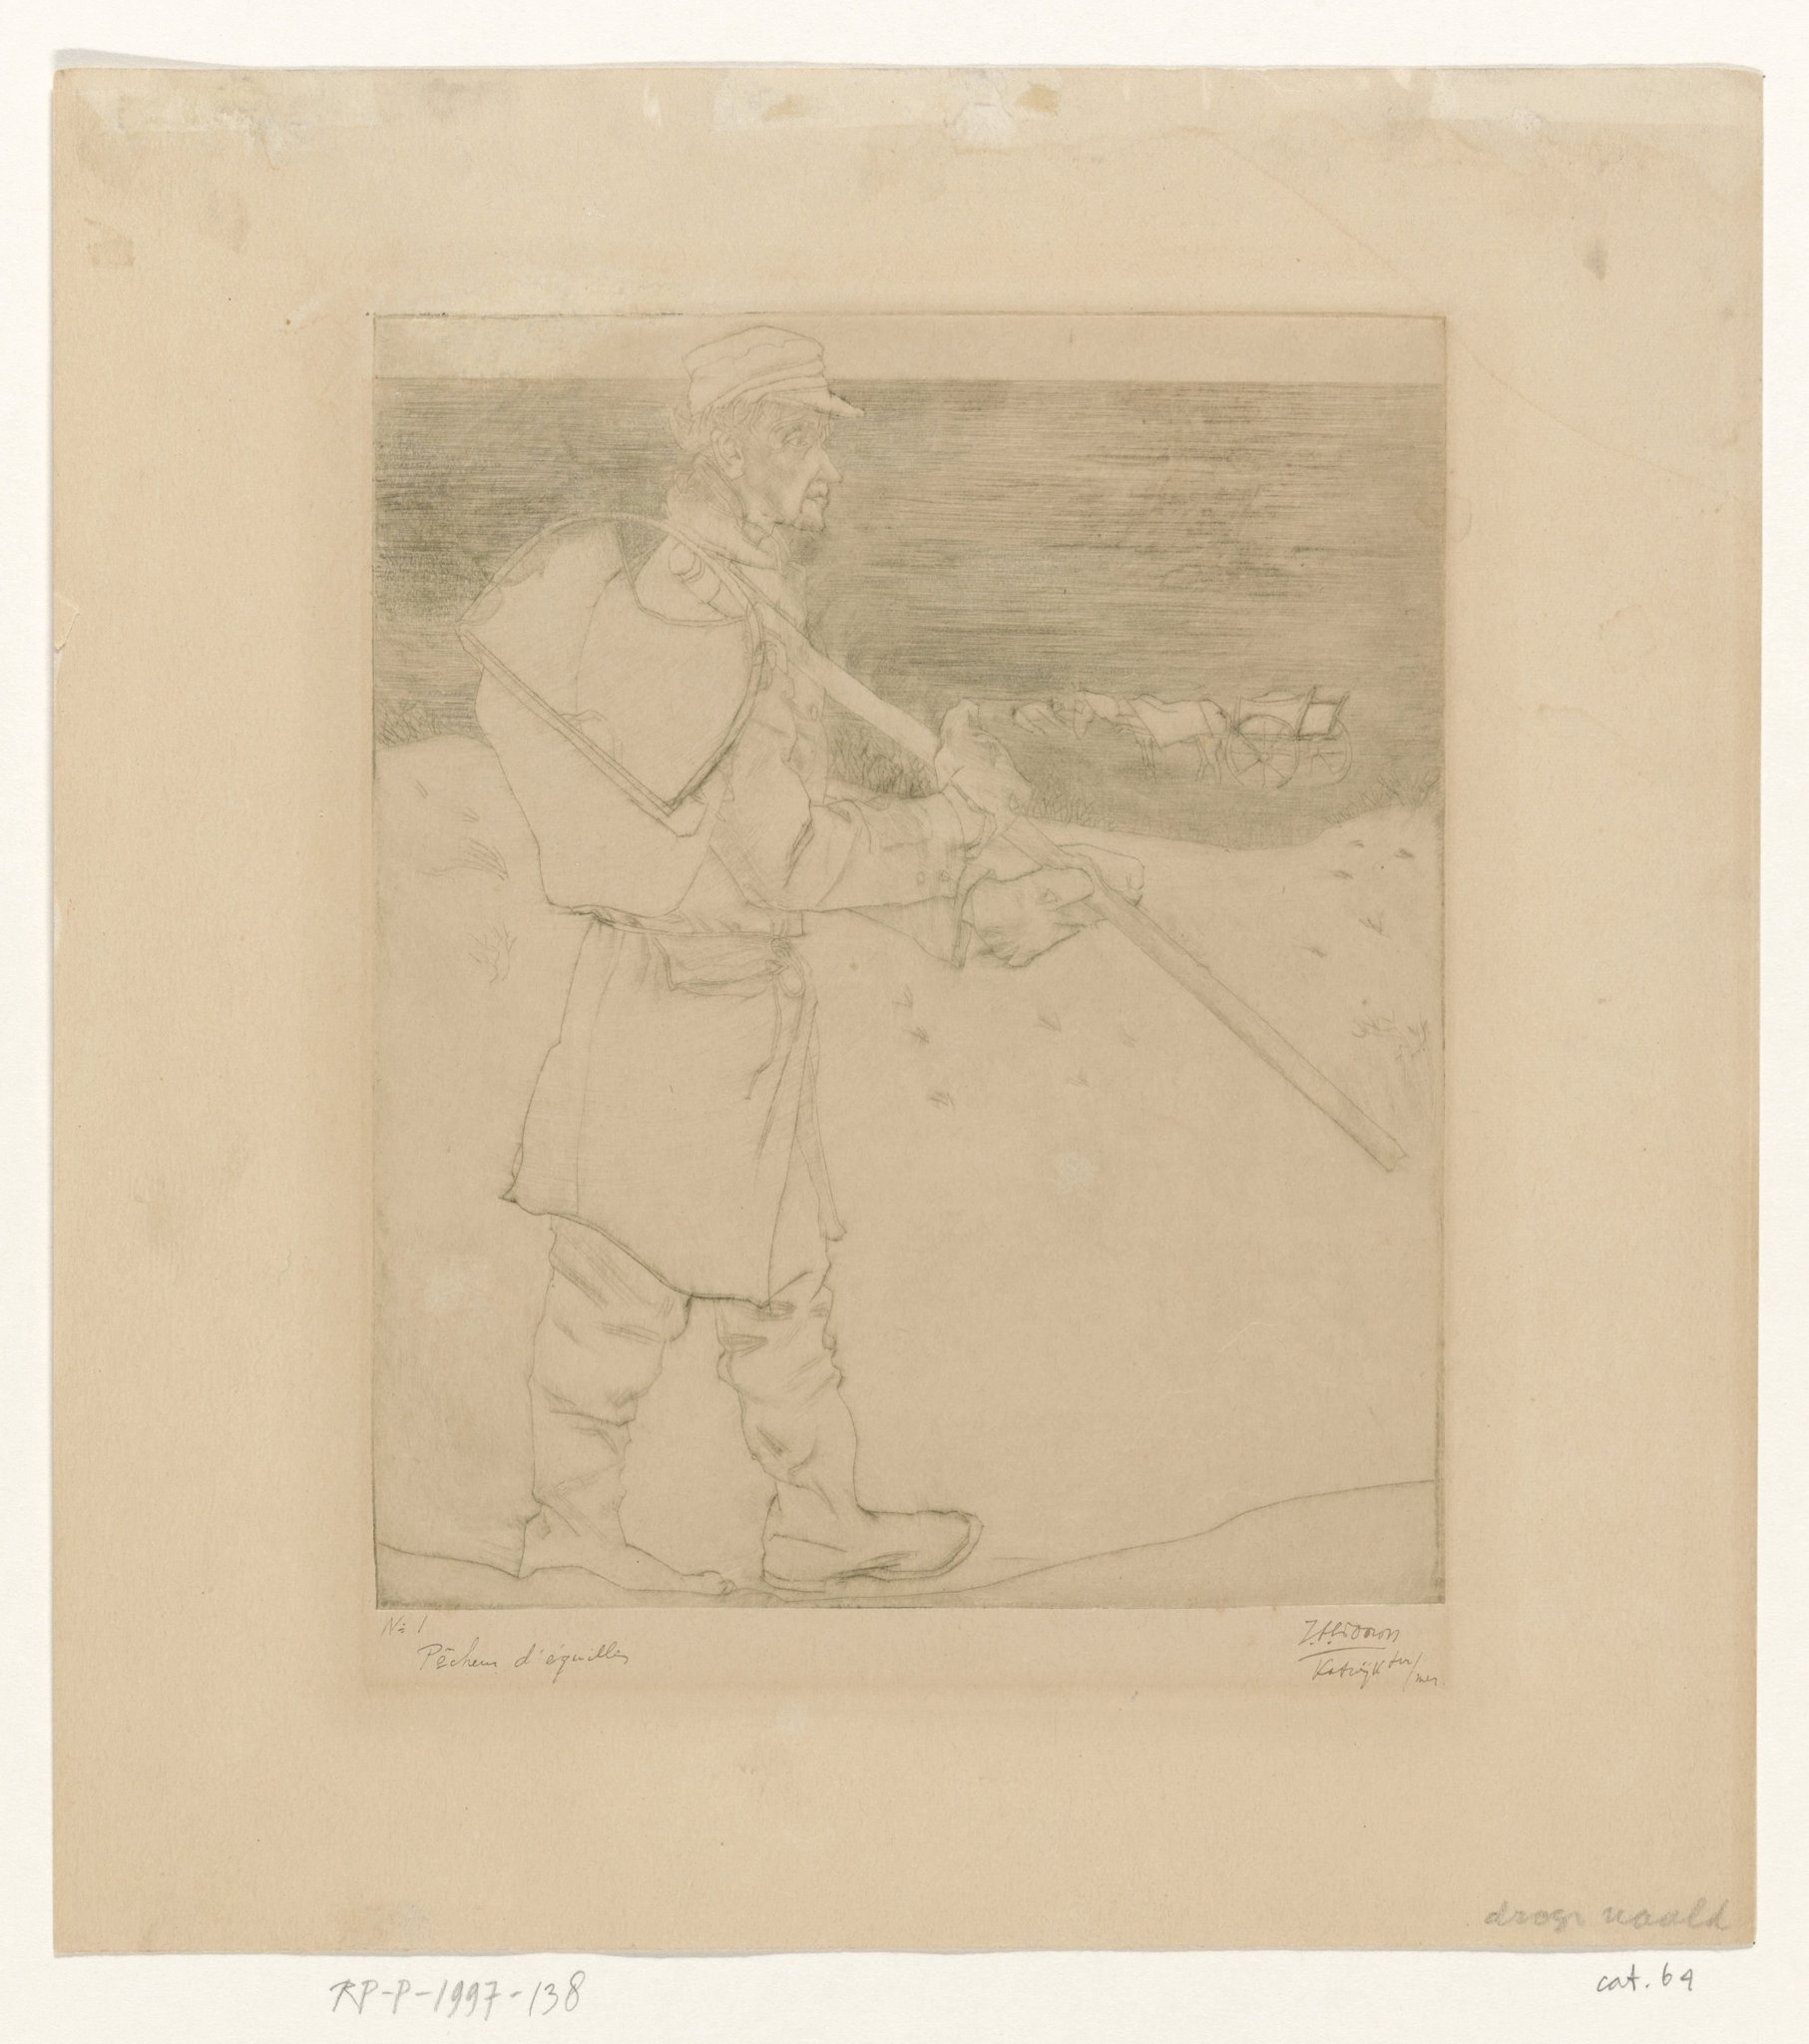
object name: print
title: De schelpenvisser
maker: jan toorop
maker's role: draughtsman, painter, print maker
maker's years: 1858-1928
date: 1902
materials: paper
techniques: drypoint, intaglio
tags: shell fishery, beach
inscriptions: annotation: ‘J.Th.Toorop/ Katwijk sur/mer’, annotation: ‘N. 1/ Pêcheur d'equilles’ Lugt 2228, collector's mark: Lugt 2228